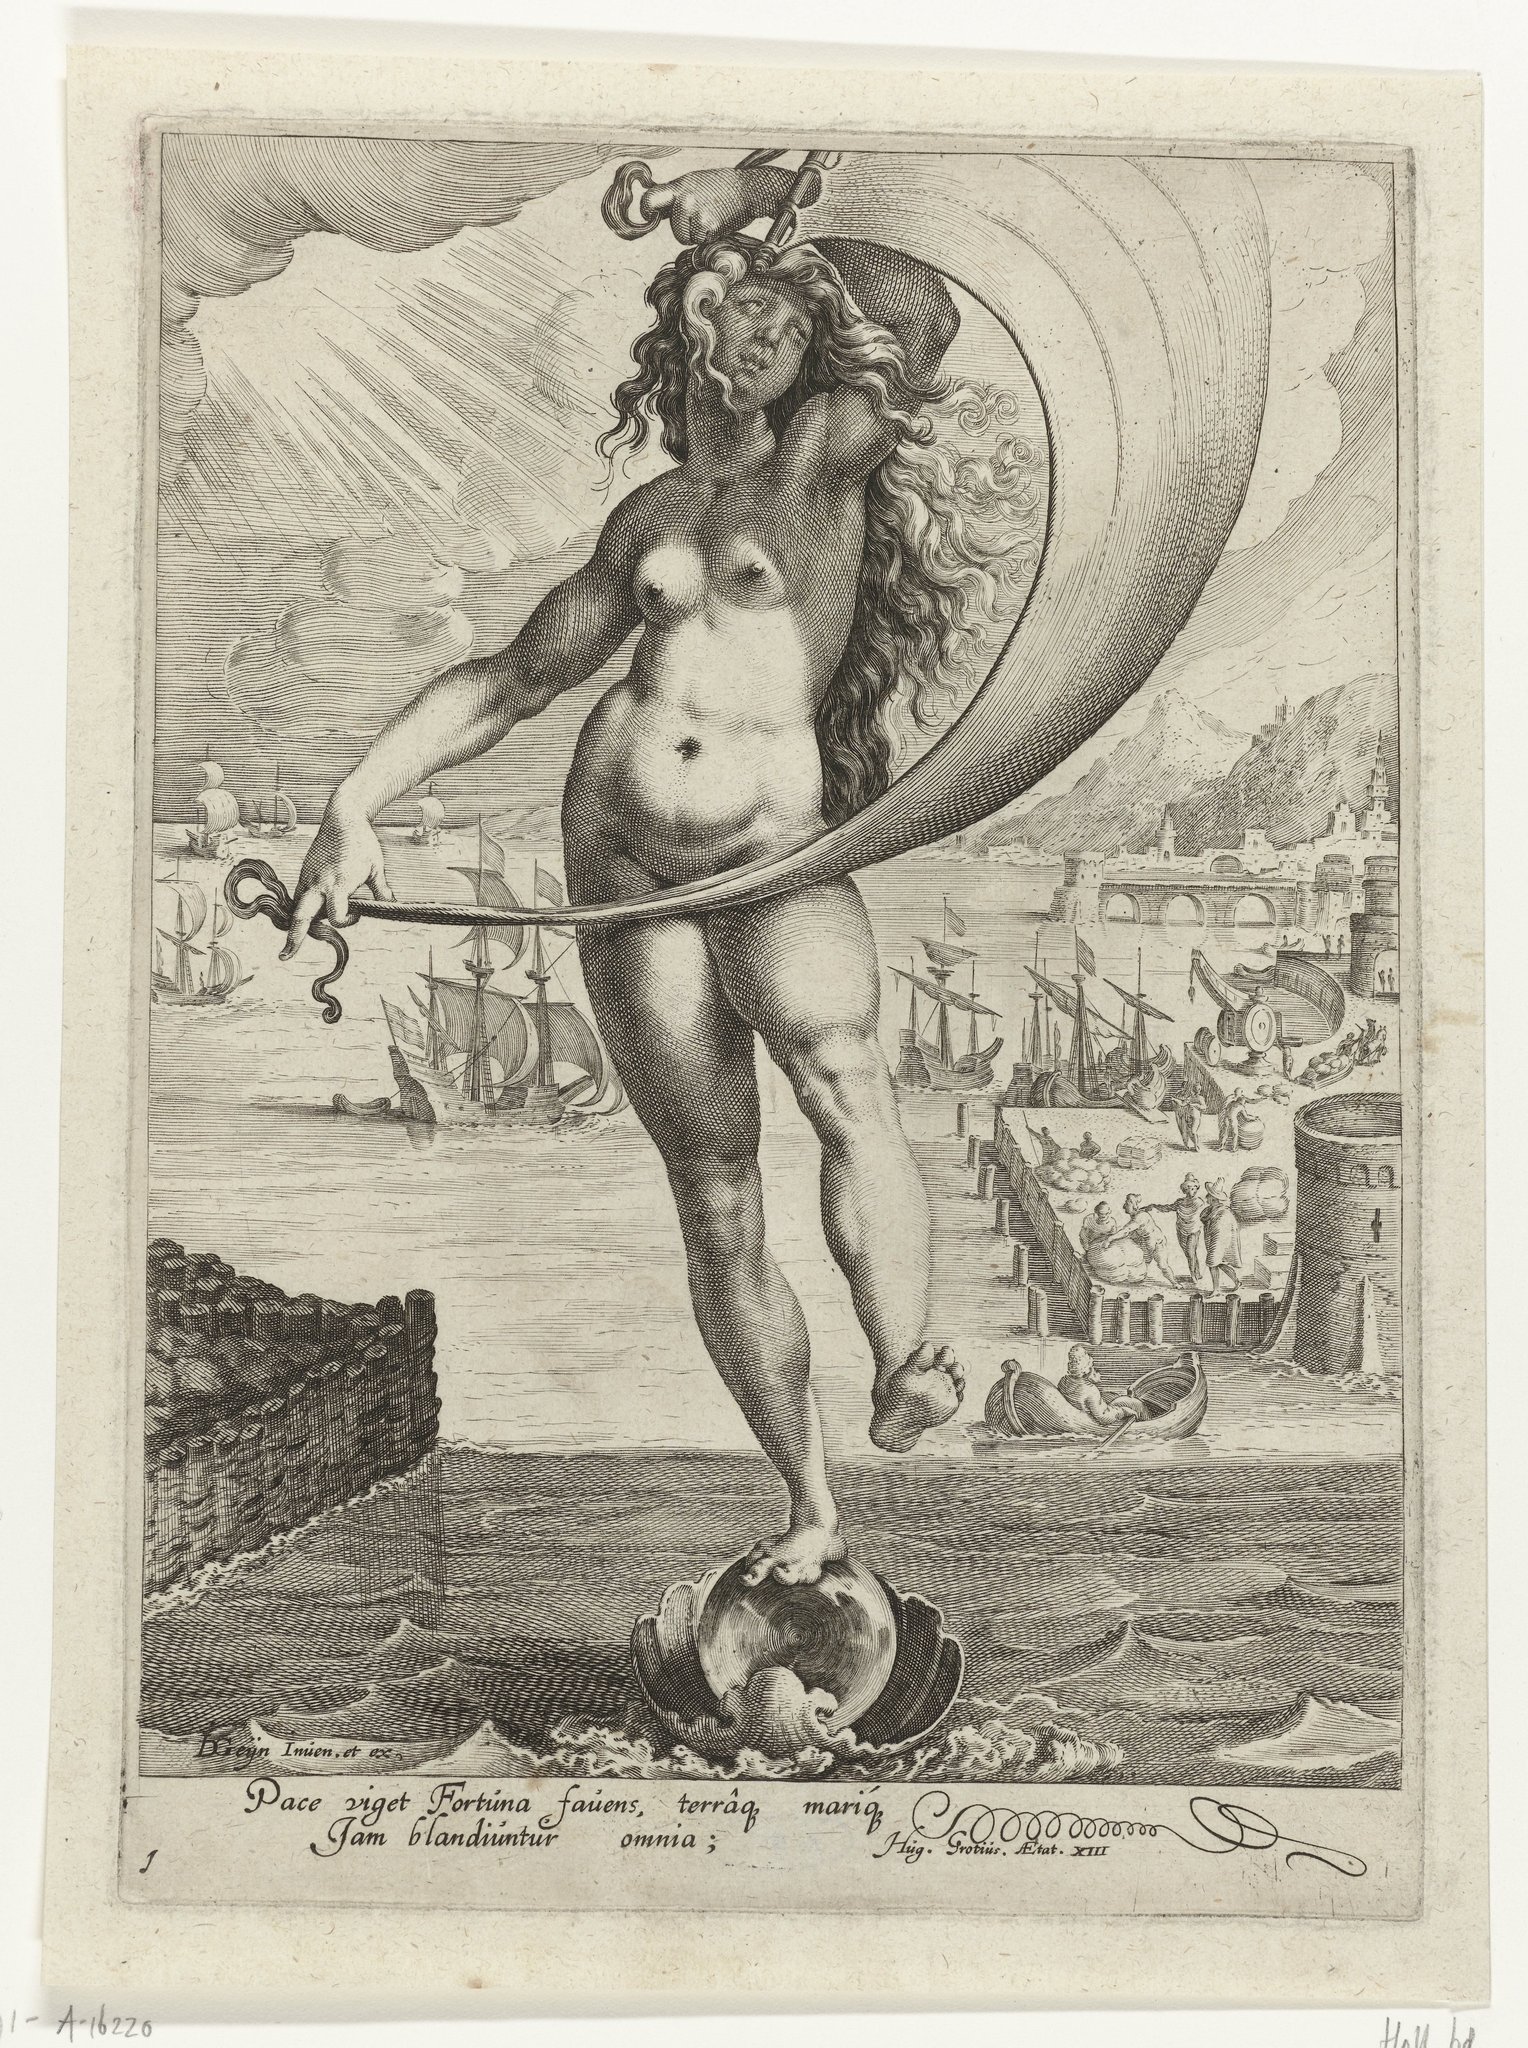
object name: print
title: De lotgevallen van het leven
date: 1596-1597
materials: paper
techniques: engraving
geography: leiden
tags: harbour, vicissitudes of life, luck, fortune, lot; 'fato', 'fortuna', 'fortuna aurea', 'fortuna buona', 'fortuna pacifica overo clemente', 'sorte' (ripa)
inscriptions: signature and address: ‘IDGheyn Inven et ex.’, number: ‘1’, caption: ‘Pace viget Fortuna favens, terraq. mariq / Iam blandiuntur omnia.’, collector's mark: Lugt 2228, signature: ‘Hug. Grotius Aetat. XIII’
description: Fortuna staat op een schelp in het water. Op de achtergrond een haven. Nr. 1 uit serie deugden en ondeugden die de lotgevallen van het menselijk leven bepalen.